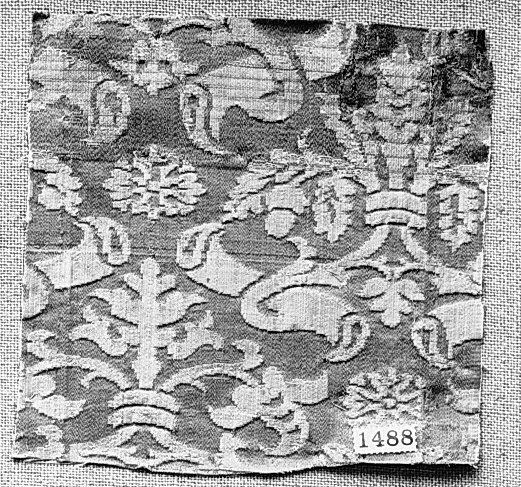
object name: piece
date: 1501-1600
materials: silk